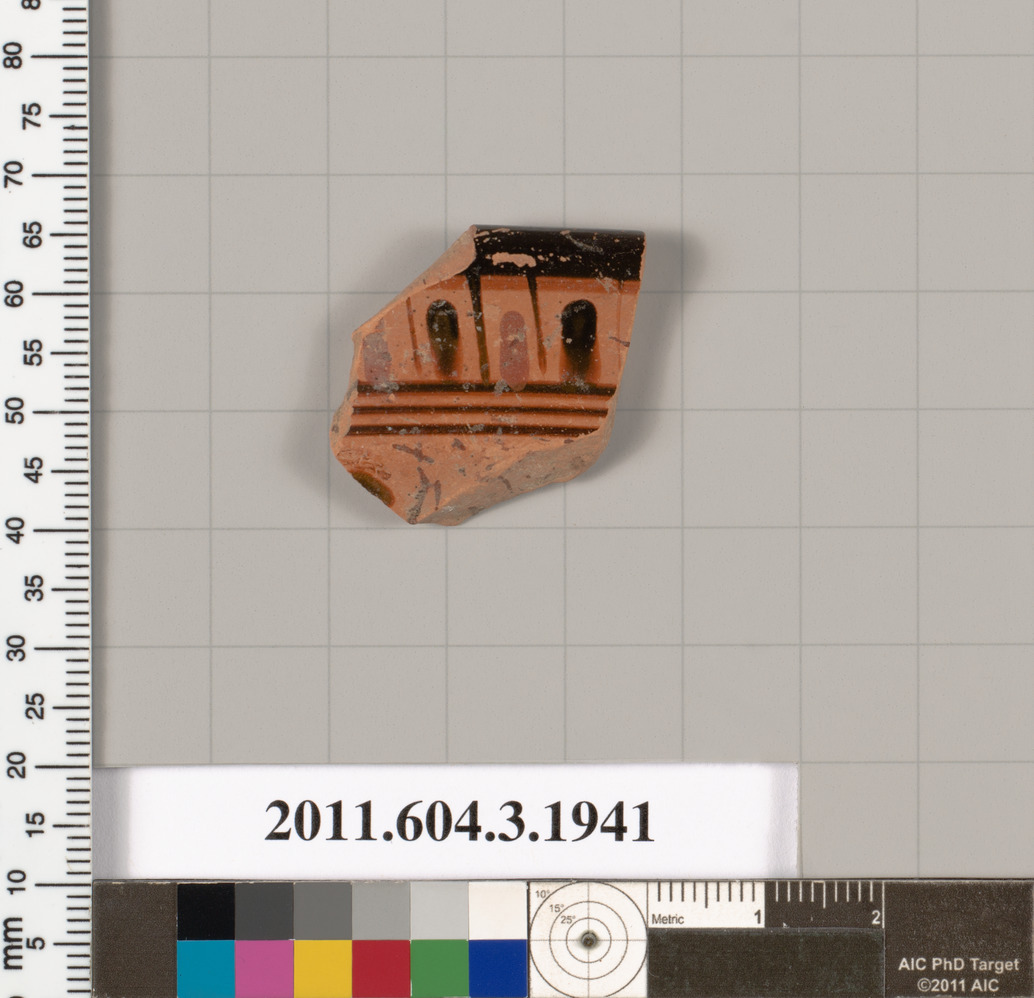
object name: kylix fragment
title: Terracotta rim fragment of a kylix: Cassel cup (drinking cup)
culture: greek, attic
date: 550-526 BCE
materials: terracotta